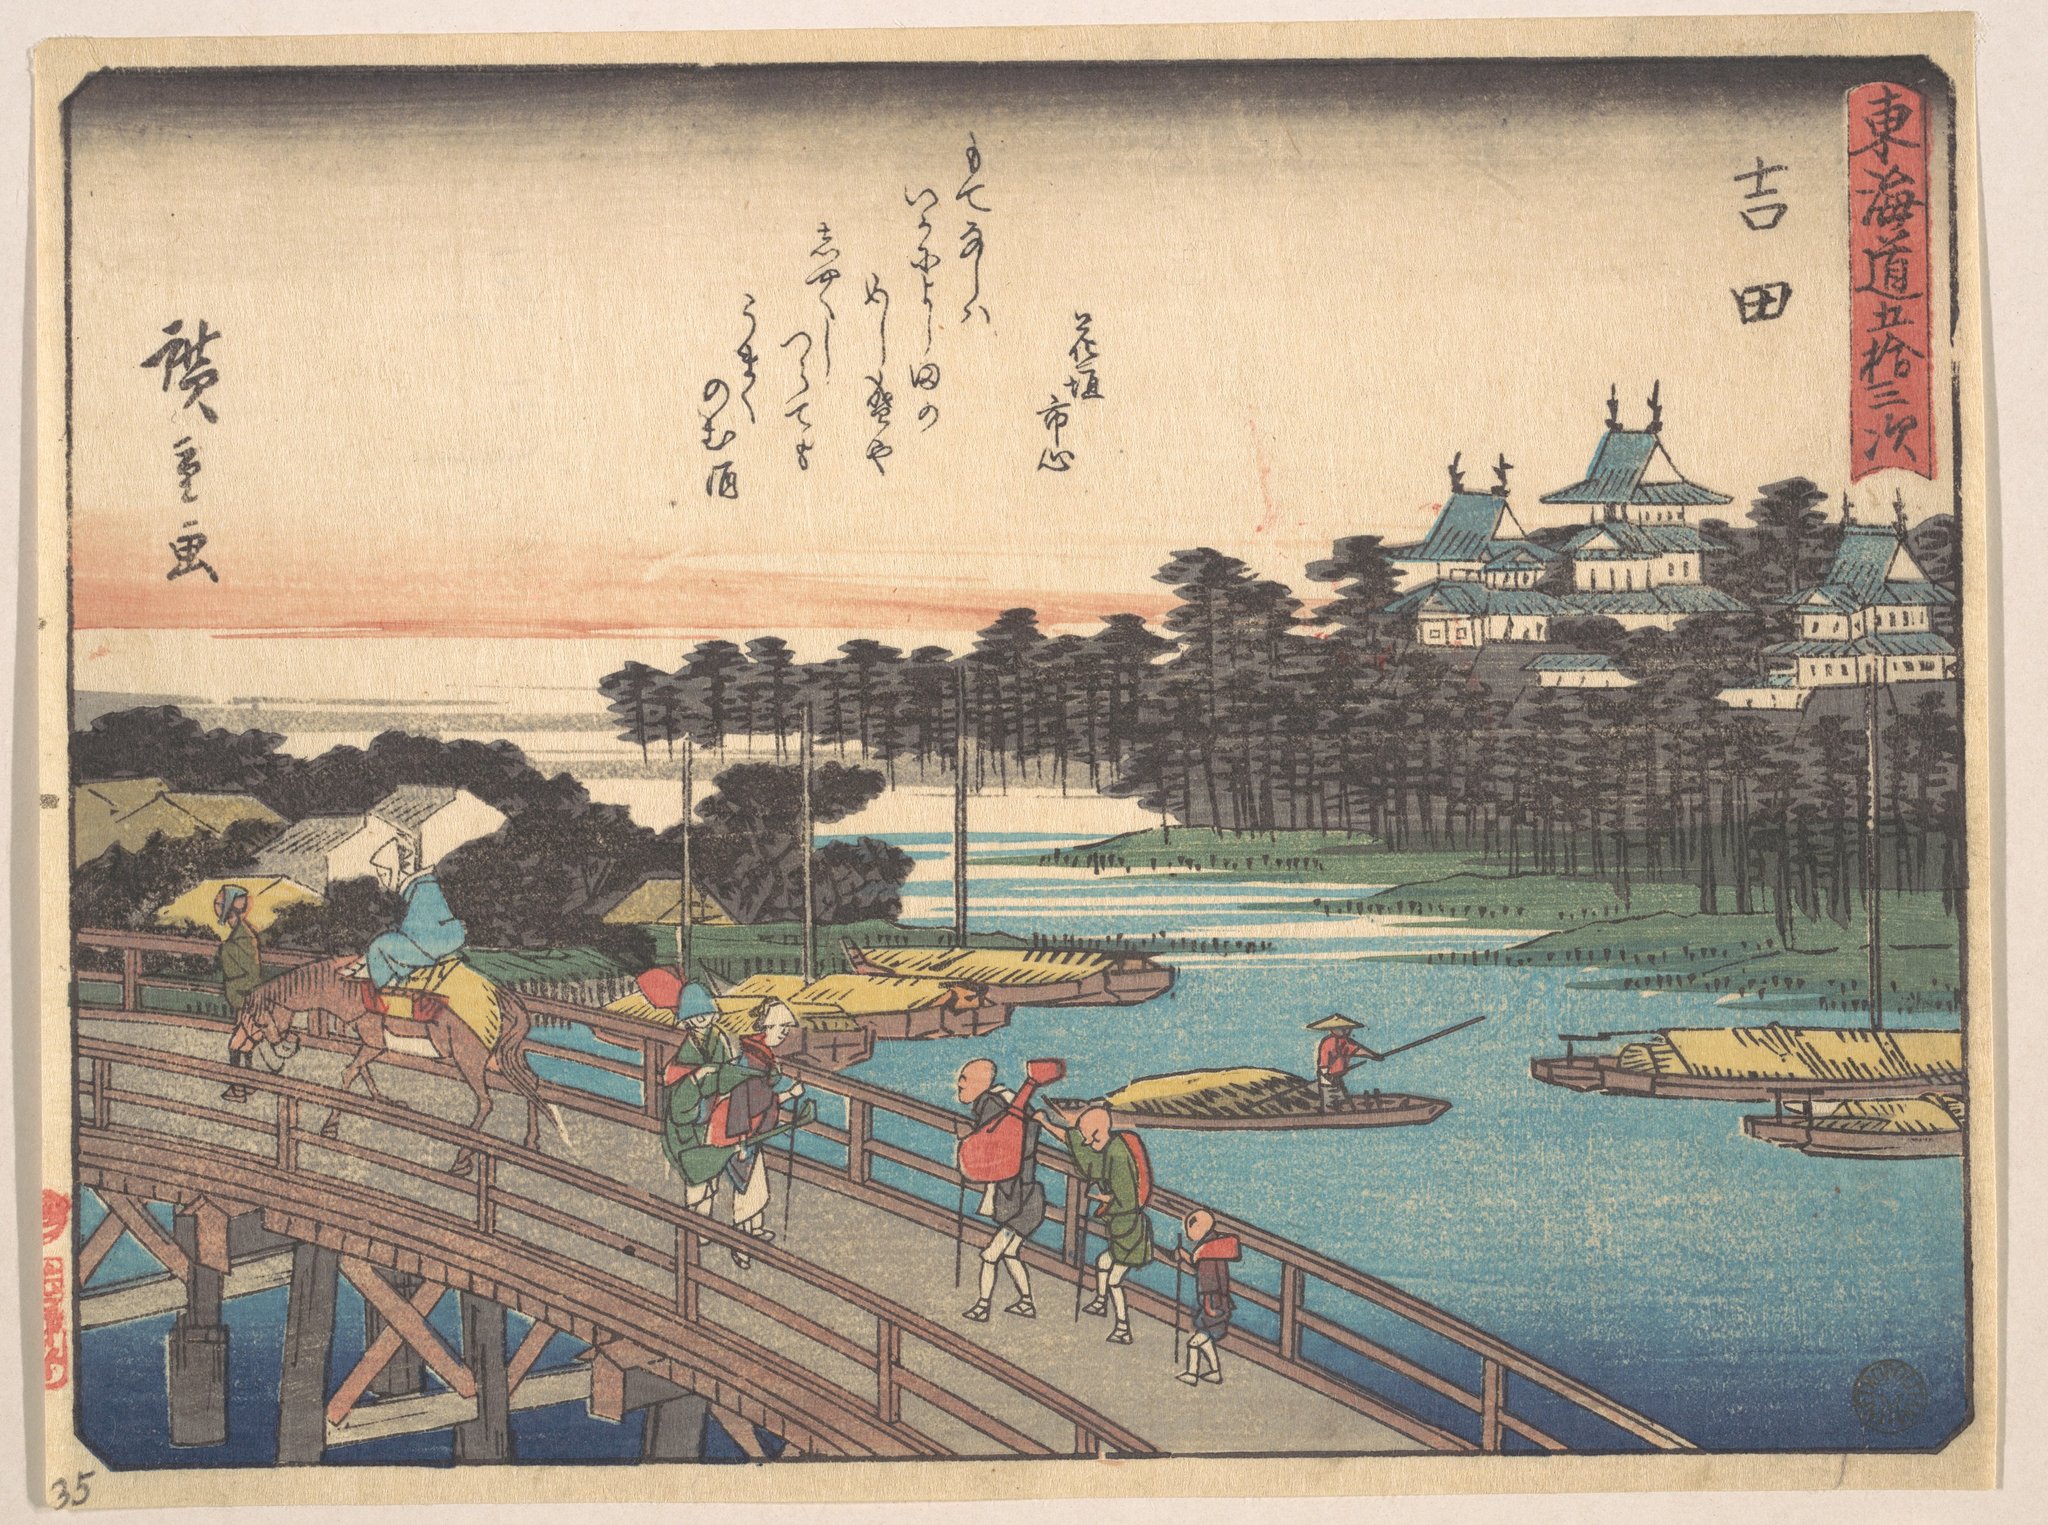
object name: print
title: Yoshida; Toyokawa-Bashi, Toyokawa Bridge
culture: japanese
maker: utagawa hiroshige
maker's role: artist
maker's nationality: japanese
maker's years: 1797-1858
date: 1838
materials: ink, paper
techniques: woodblock print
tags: houses,bridges,trees,boats